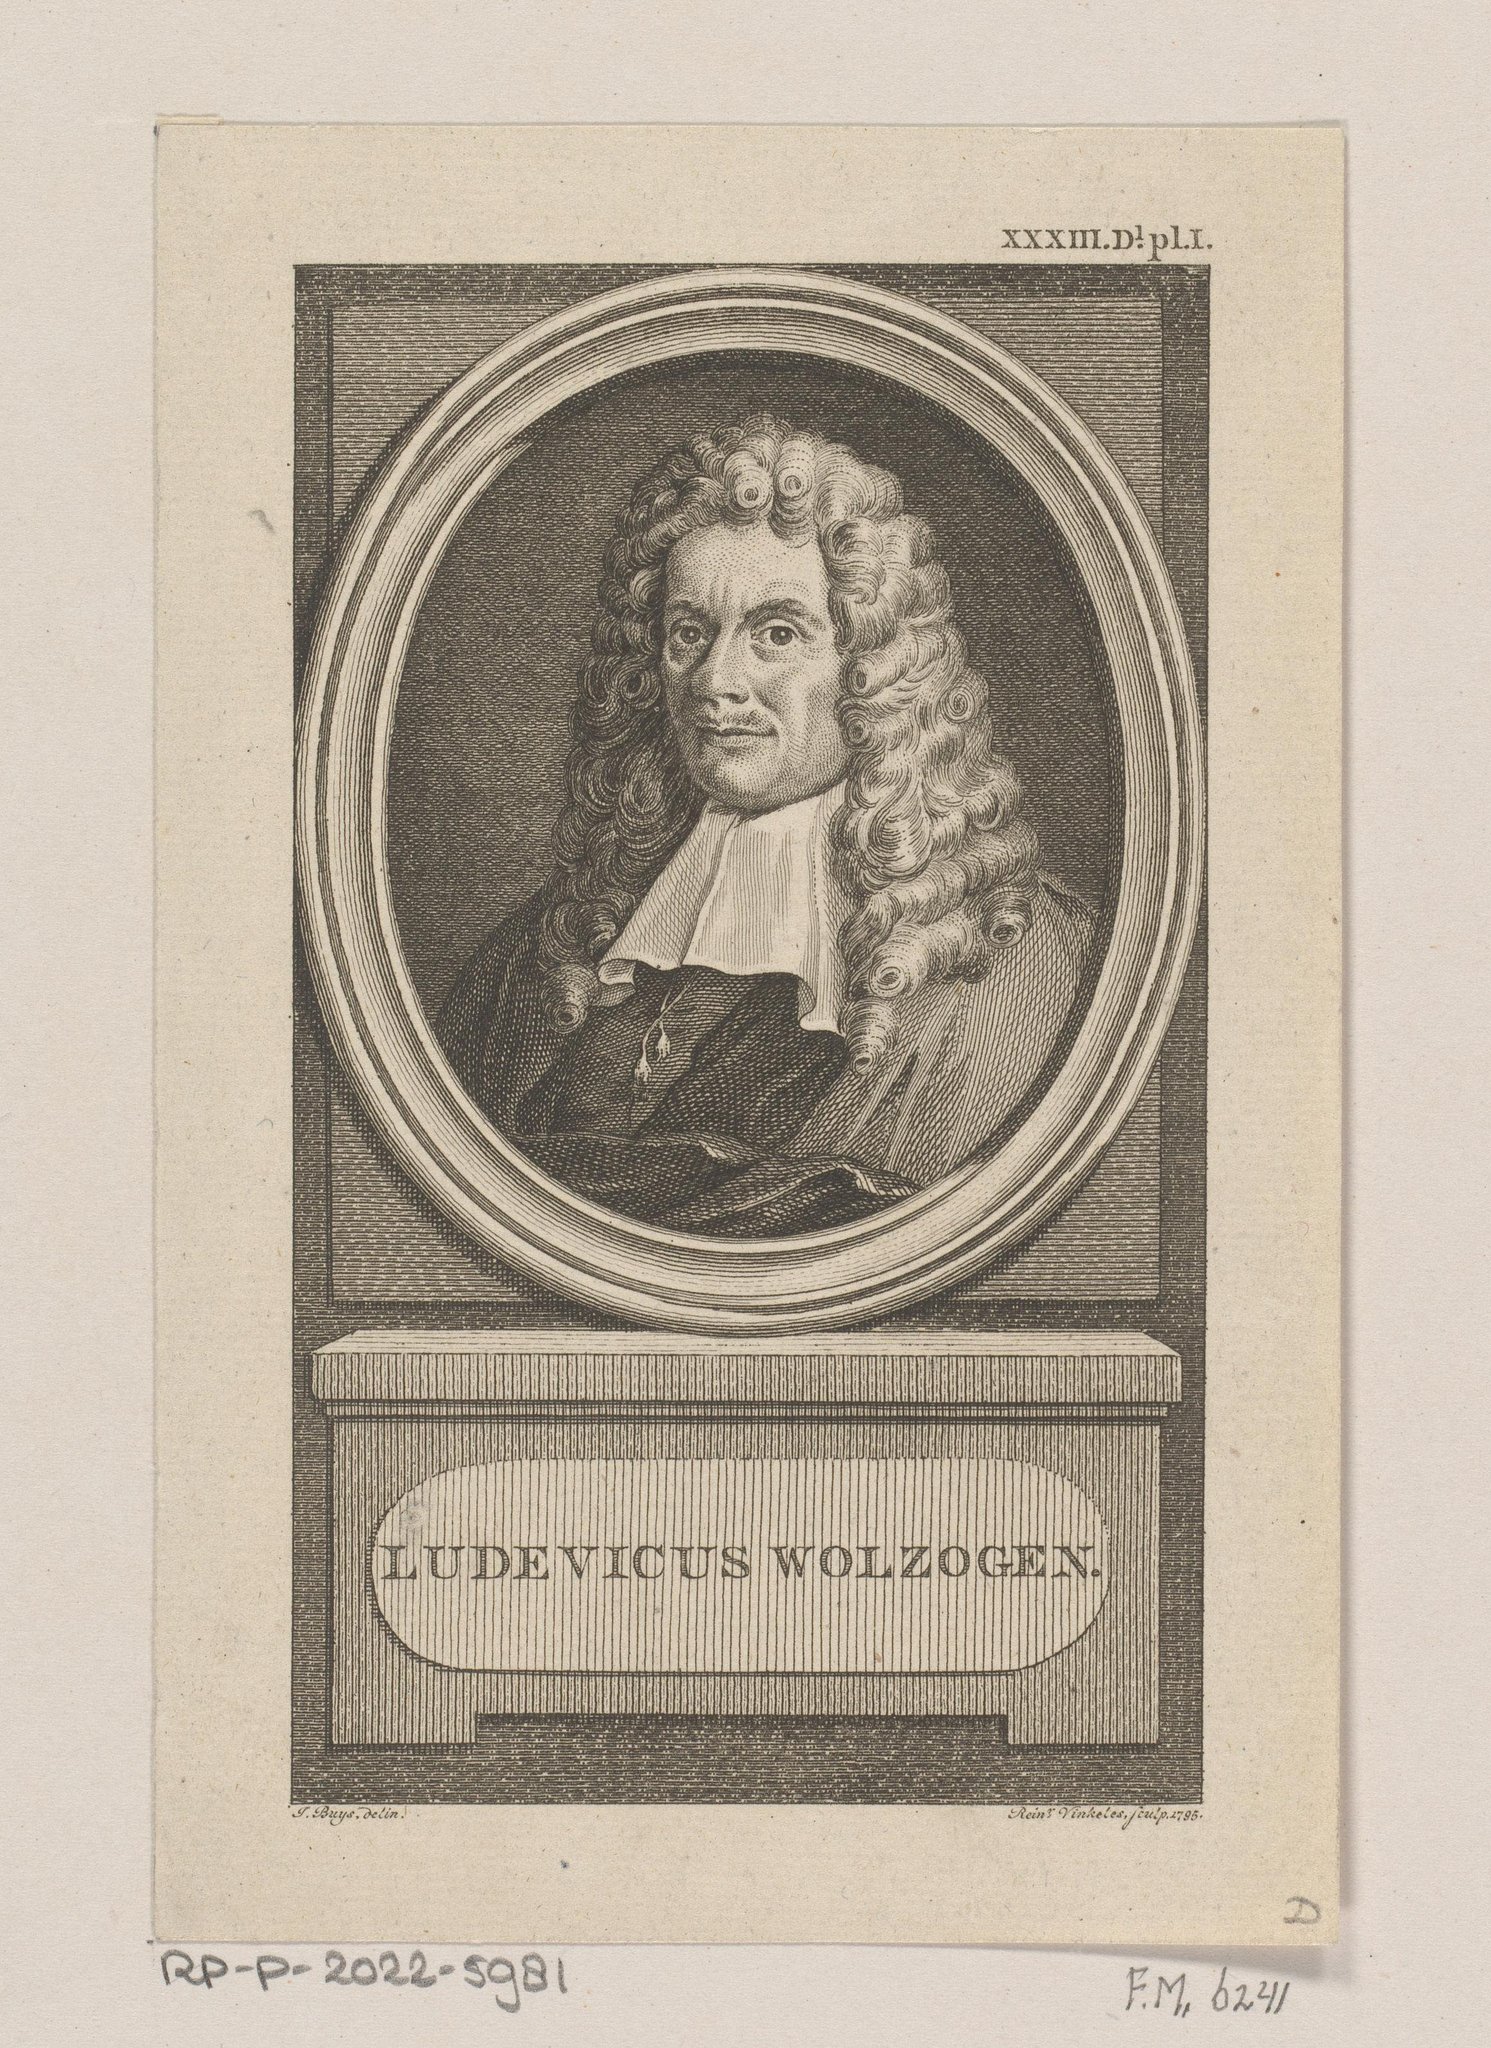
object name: print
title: Portret van Ludovicus Wolzogen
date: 1795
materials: paper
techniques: engraving, etching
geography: amsterdam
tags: theologian, historical persons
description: Prent waarschijnlijk uit: Kok, Jacobus. Vaderlandsch woordenboek. S.l.: s.n., 1795, dl. 33-34.